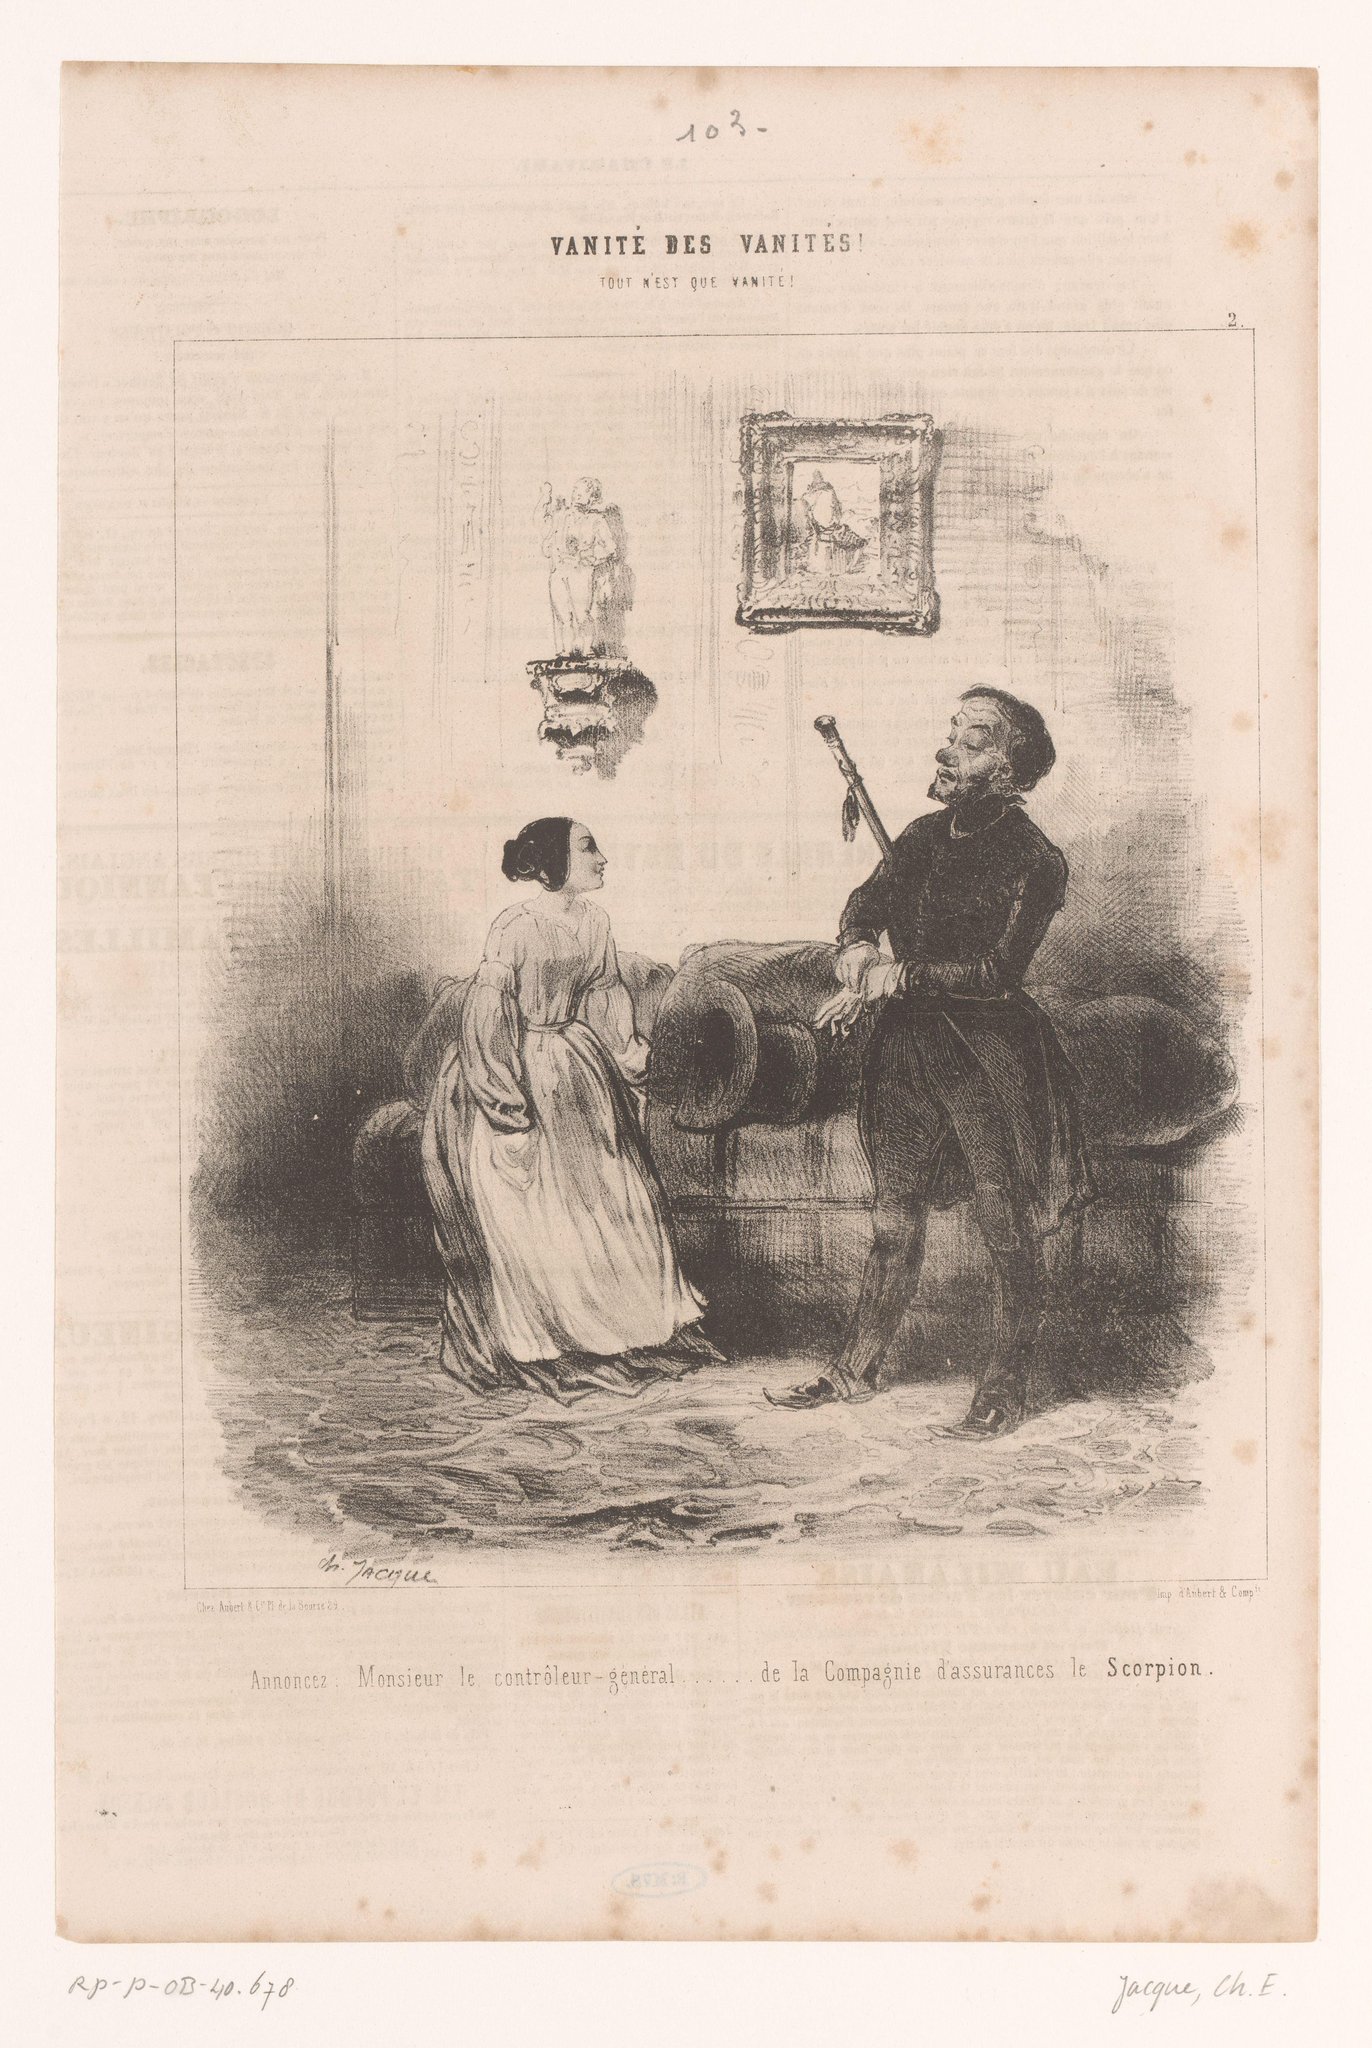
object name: print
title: Vanité des Vanités! Tout n'est que vanité!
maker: charles emile jacque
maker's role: draughtsman, painter, print maker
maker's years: 1813-1894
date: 1843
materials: paper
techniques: lithograph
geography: paris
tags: caricatures (human types), insurance agent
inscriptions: collector's mark: Lugt 2228a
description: Prent gebruikt voor: Le Charivari, 1843.